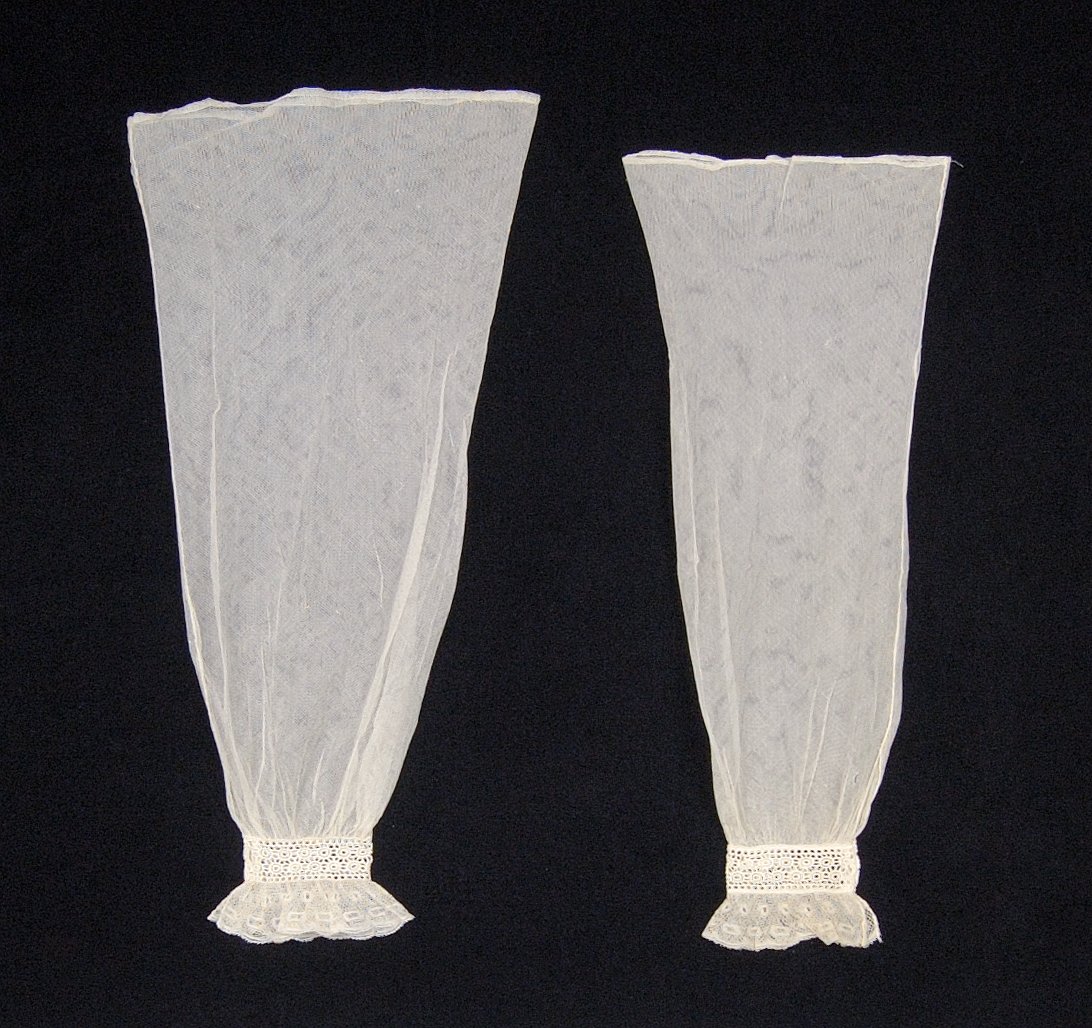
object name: undersleeves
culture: american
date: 1850-1869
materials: cotton